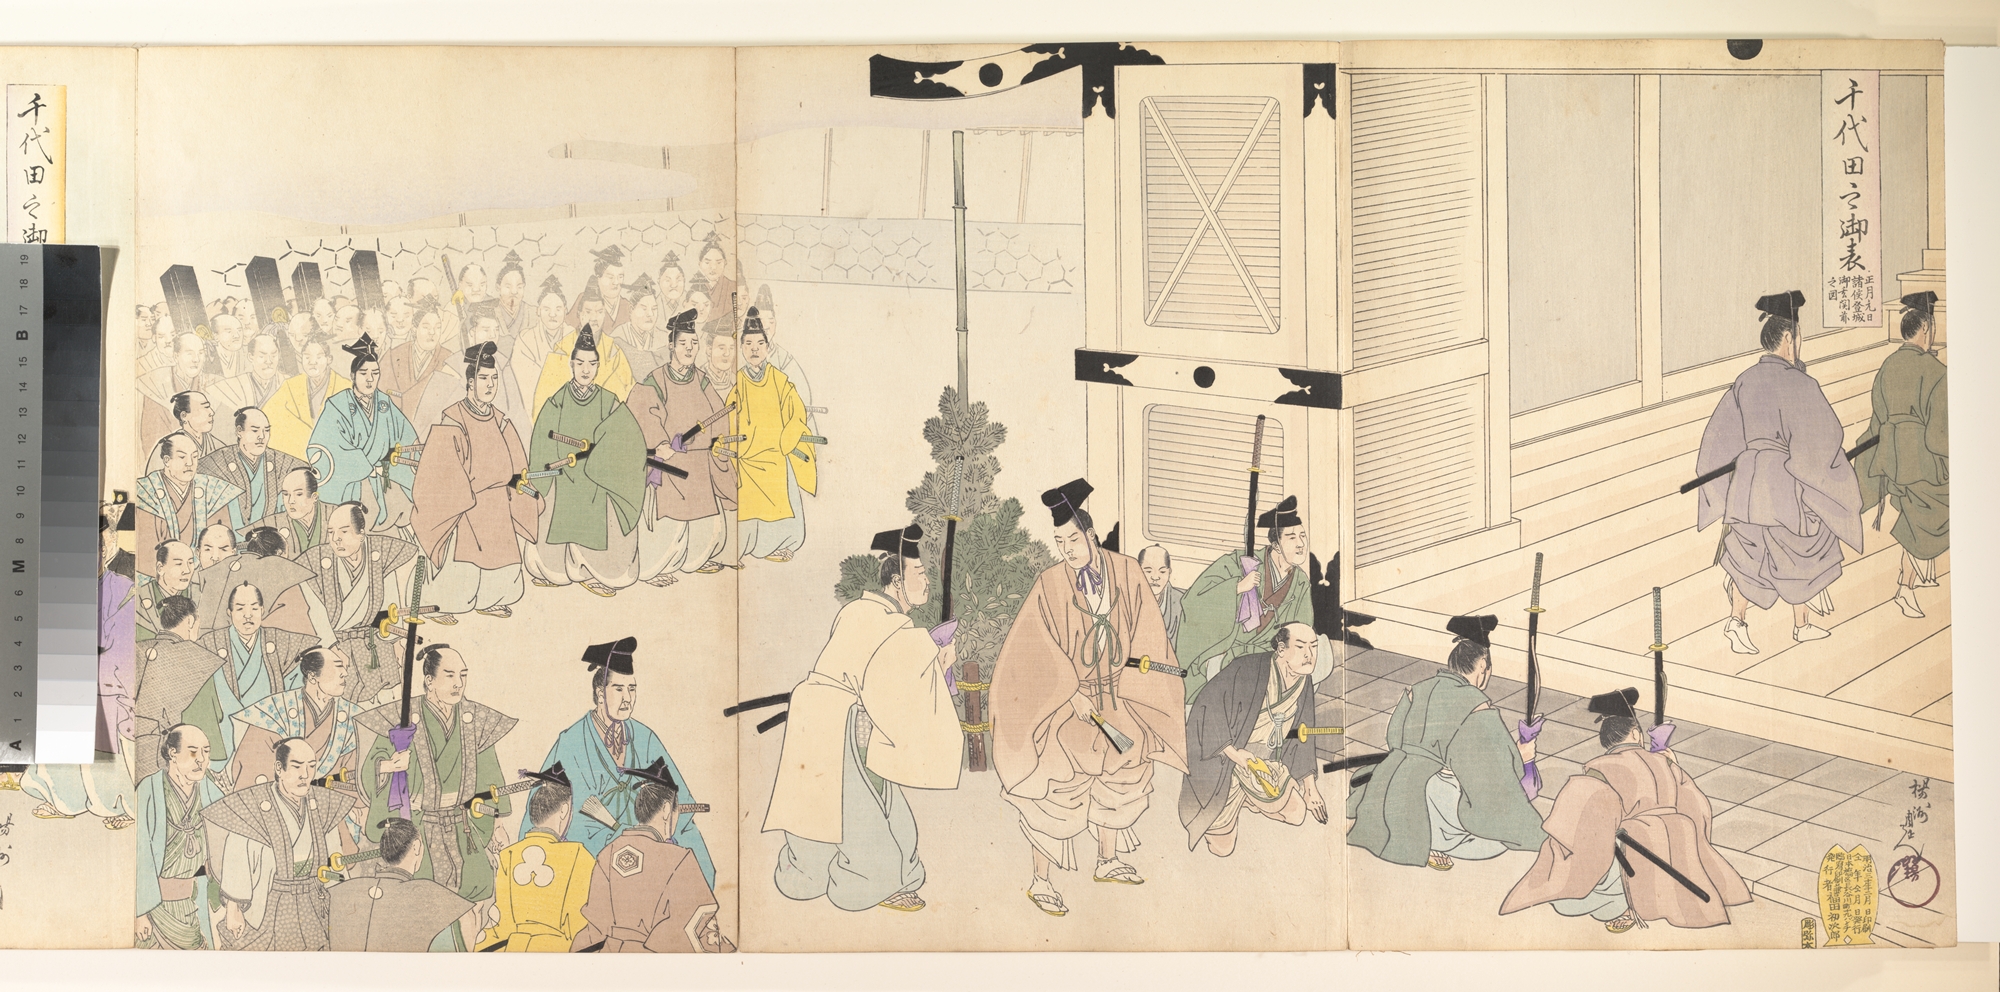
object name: print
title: Chiyoda Castle (Album of Men)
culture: japanese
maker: yōshū (hashimoto) chikanobu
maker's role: artist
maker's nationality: japanese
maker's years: 1838-1912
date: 1897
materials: ink, paper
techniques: woodblock print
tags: weapons,men